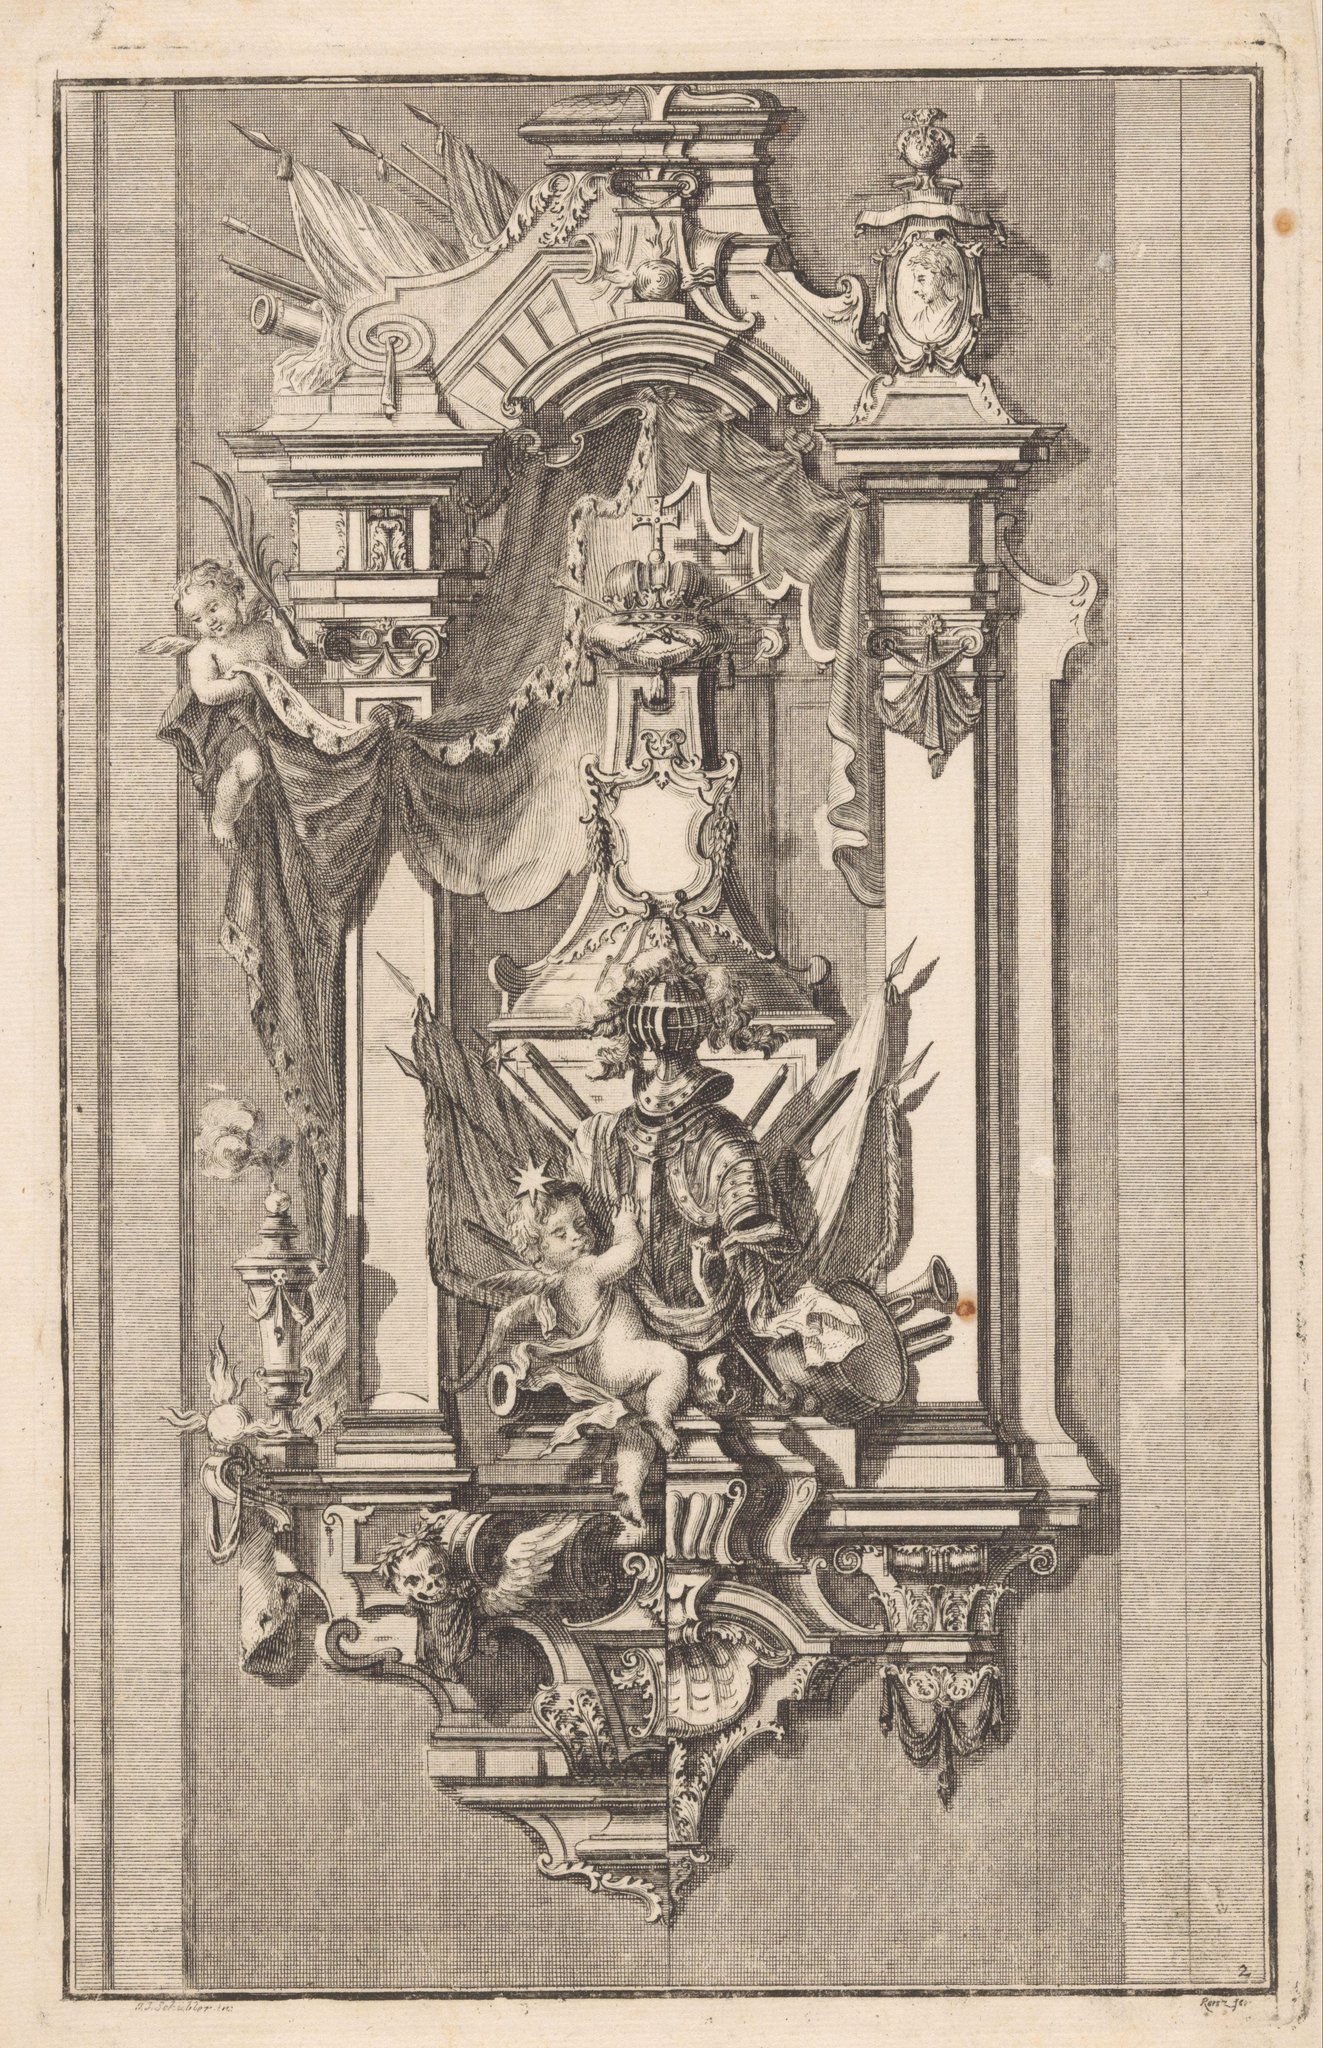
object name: print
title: Epitaaf met harnas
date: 1711-1726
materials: paper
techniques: engraving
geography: nuremberg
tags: armour, weapons, epitaph, cupids: 'amores', 'amoretti', 'putti'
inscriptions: collector's mark: Lugt 2760, collector's mark: Lugt 2228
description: Een geornamenteerde epitaaf gedecoreerd met wapens, kogels en vlaggen. In het midden vliegt een putto met een ster op het hoofd bij een harnas omgeven door muziekinstrumenten, wapens en vlaggen. Daarboven een cartouche en een kroon met kruis en scepter. Links vliegt een gevleugelde putto met een palmtak, hij houdt een doek vast.